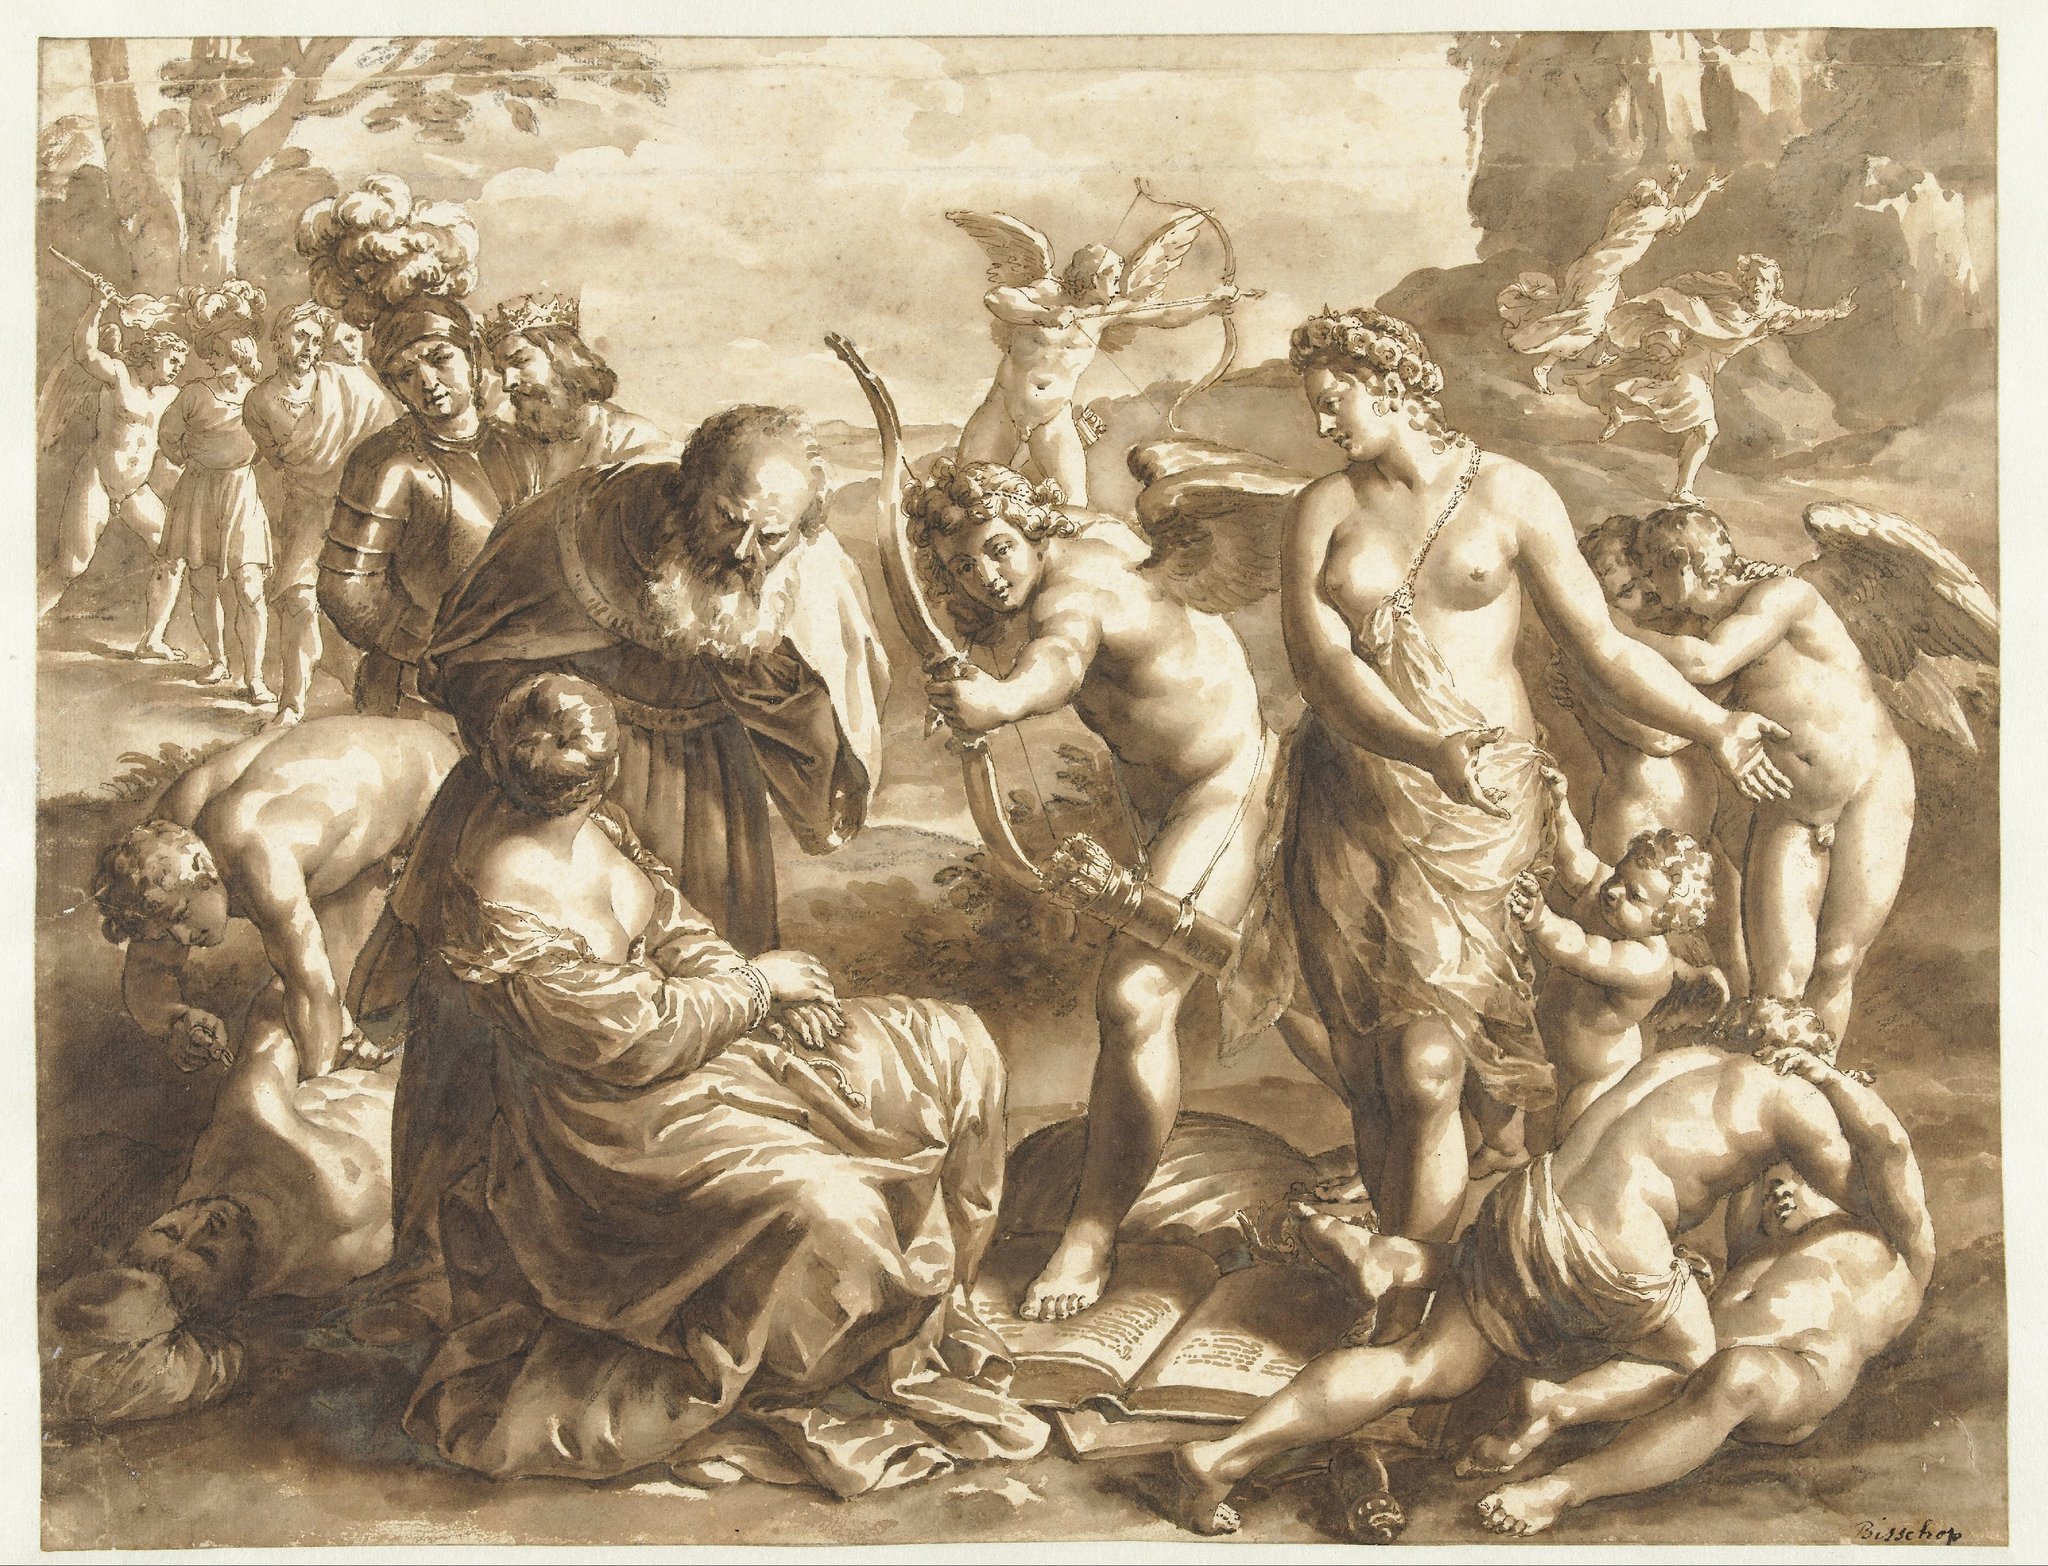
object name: drawing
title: Allegory of the Power of Venus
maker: jan de bisschop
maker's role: draughtsman, print maker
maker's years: 1628-1671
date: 1638-1671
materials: chalk, ink, paper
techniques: brush, pen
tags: cupid shooting a dart, love personified, cupid disarming the strong; the power of love, specific aspects, allegorical aspects of venus; venus as patroness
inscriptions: : ‘Amor vincit Omnia’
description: No one is safe from Cupid’s love arrows; not a king, nor a knight, nor an old man. His mother Venus, to the right of centre, spurs him on. De Bisschop copied a painting by Alessandro Turchi, an artist from Verona, which in his time must have been in the possession of a Dutch collector. The picture is now in the Mauritshuis in The Hague.